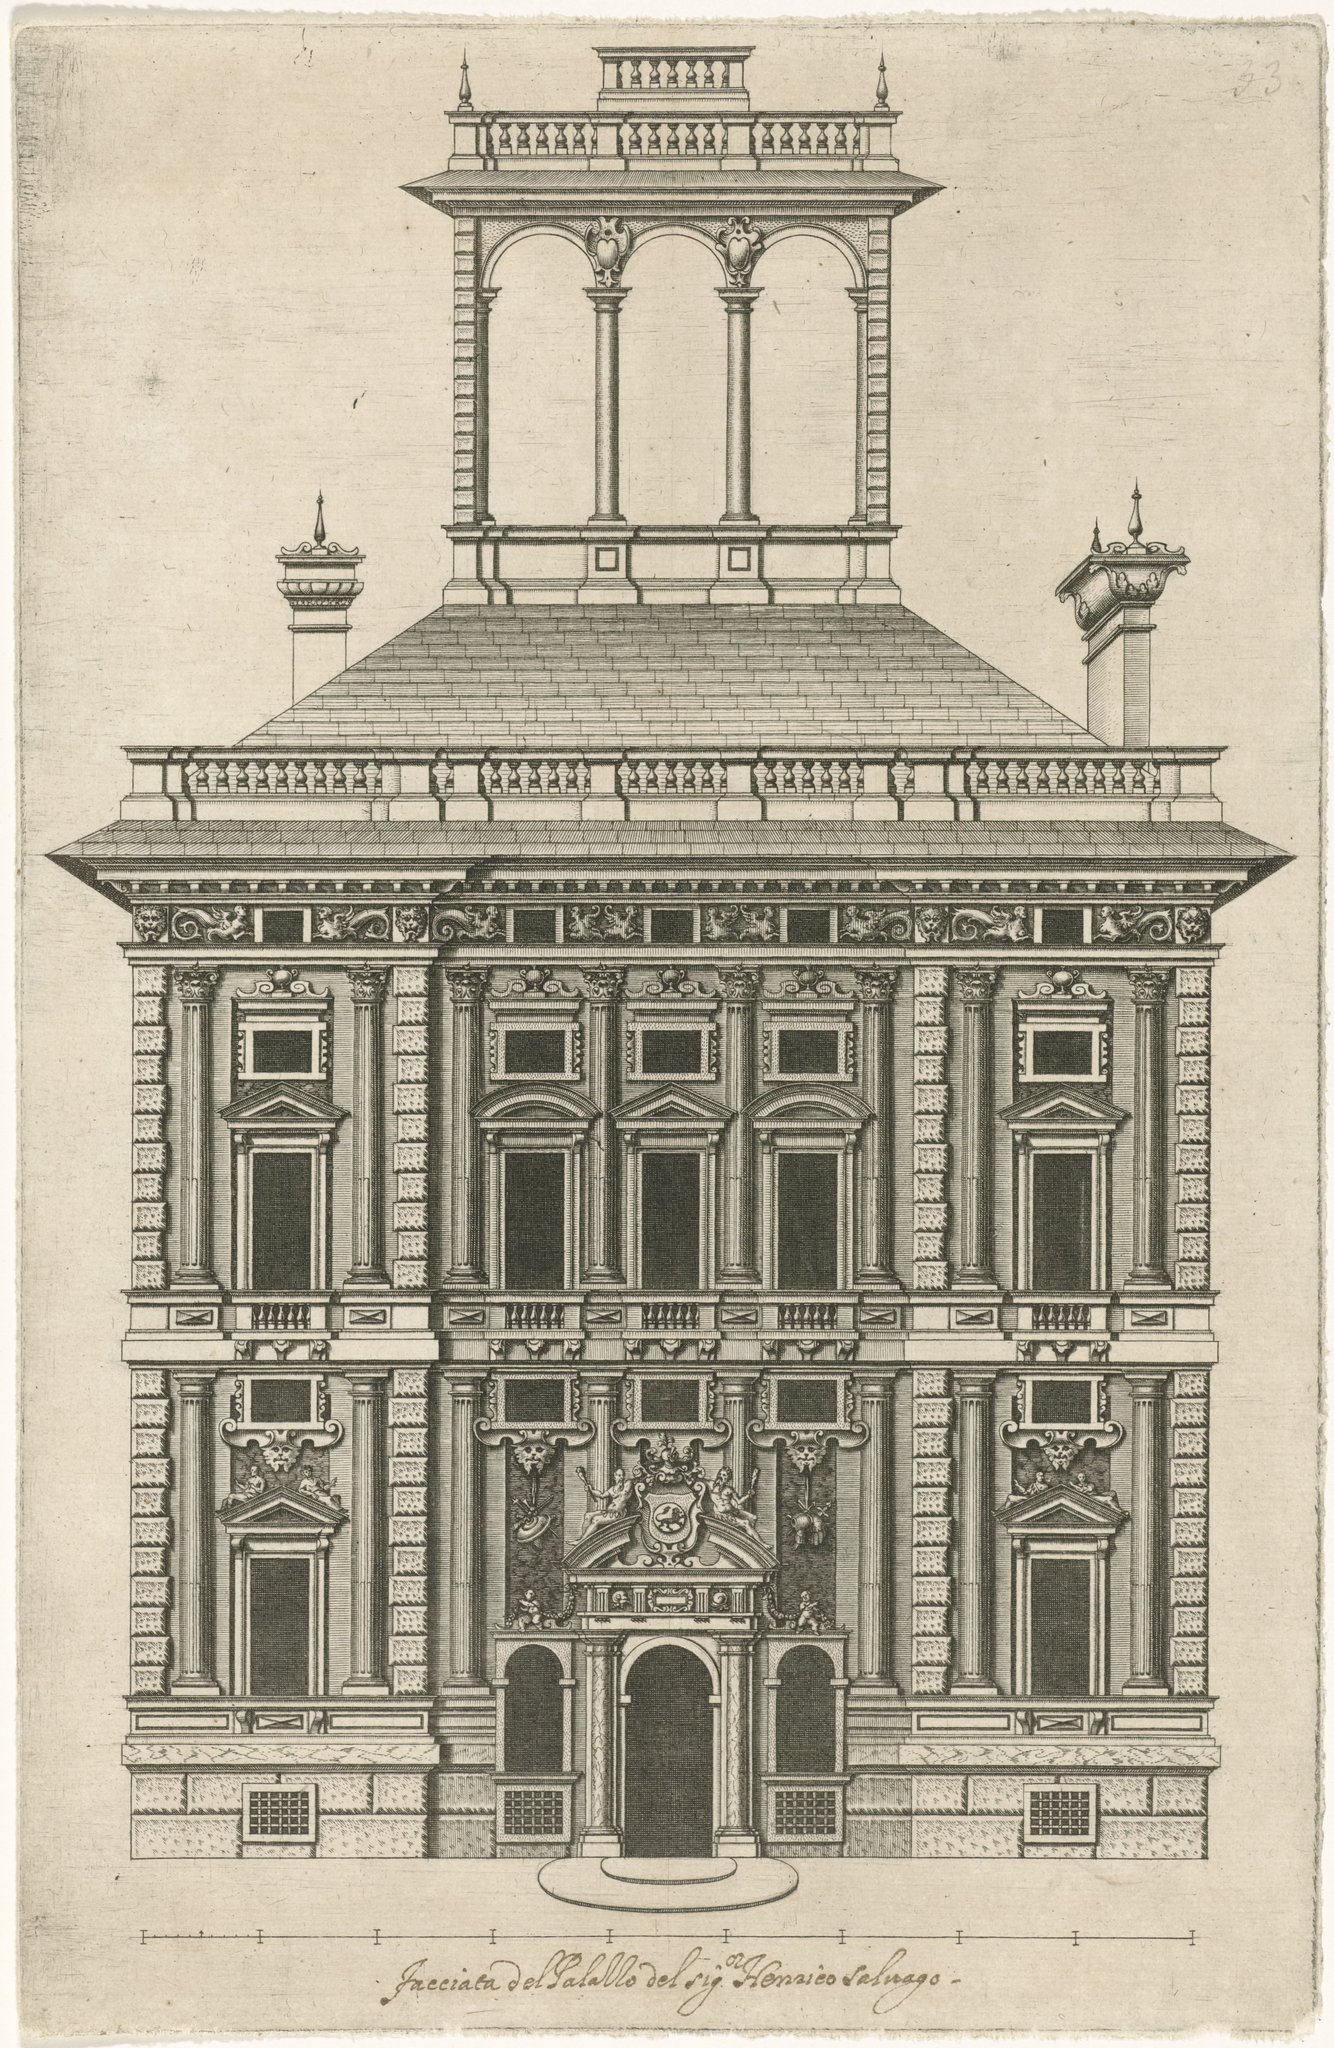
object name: print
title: Palazzo Campanella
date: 1622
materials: paper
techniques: engraving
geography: antwerp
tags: façade (of house or building)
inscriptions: inscription: ‘Facciata del Palasso del Sig. Henrico Salvago’, collector's mark: Lugt 240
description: Voorgevel van Palazzo Campanella, gelegen aan de via Garibaldi te Genua. Het palazzo werd in 1563 in opdracht van Bartolomeo Lomellino onder leiding van de architect Giovanni Ponzello gebouwd.